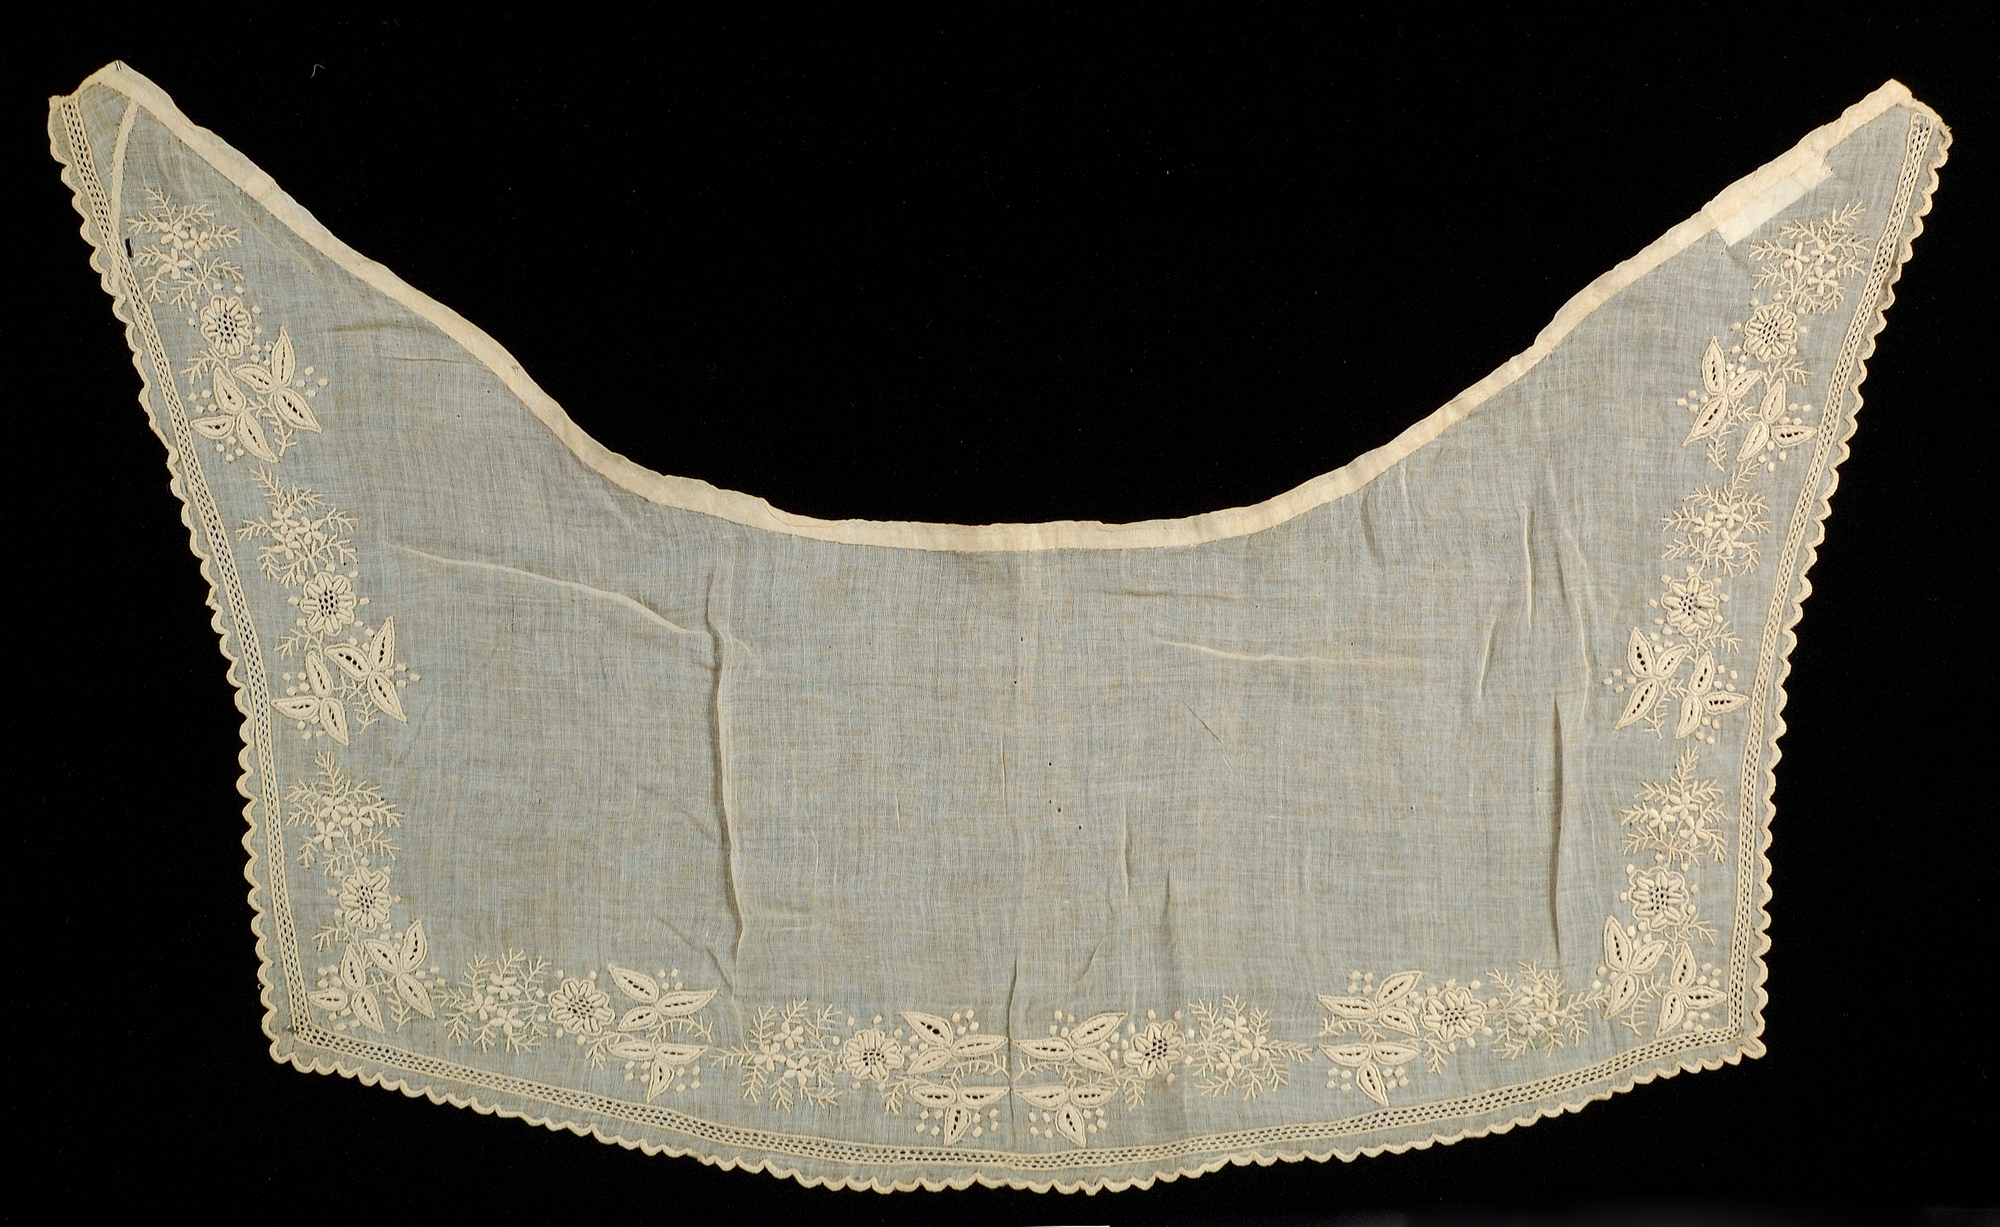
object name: collar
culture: french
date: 1850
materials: cotton